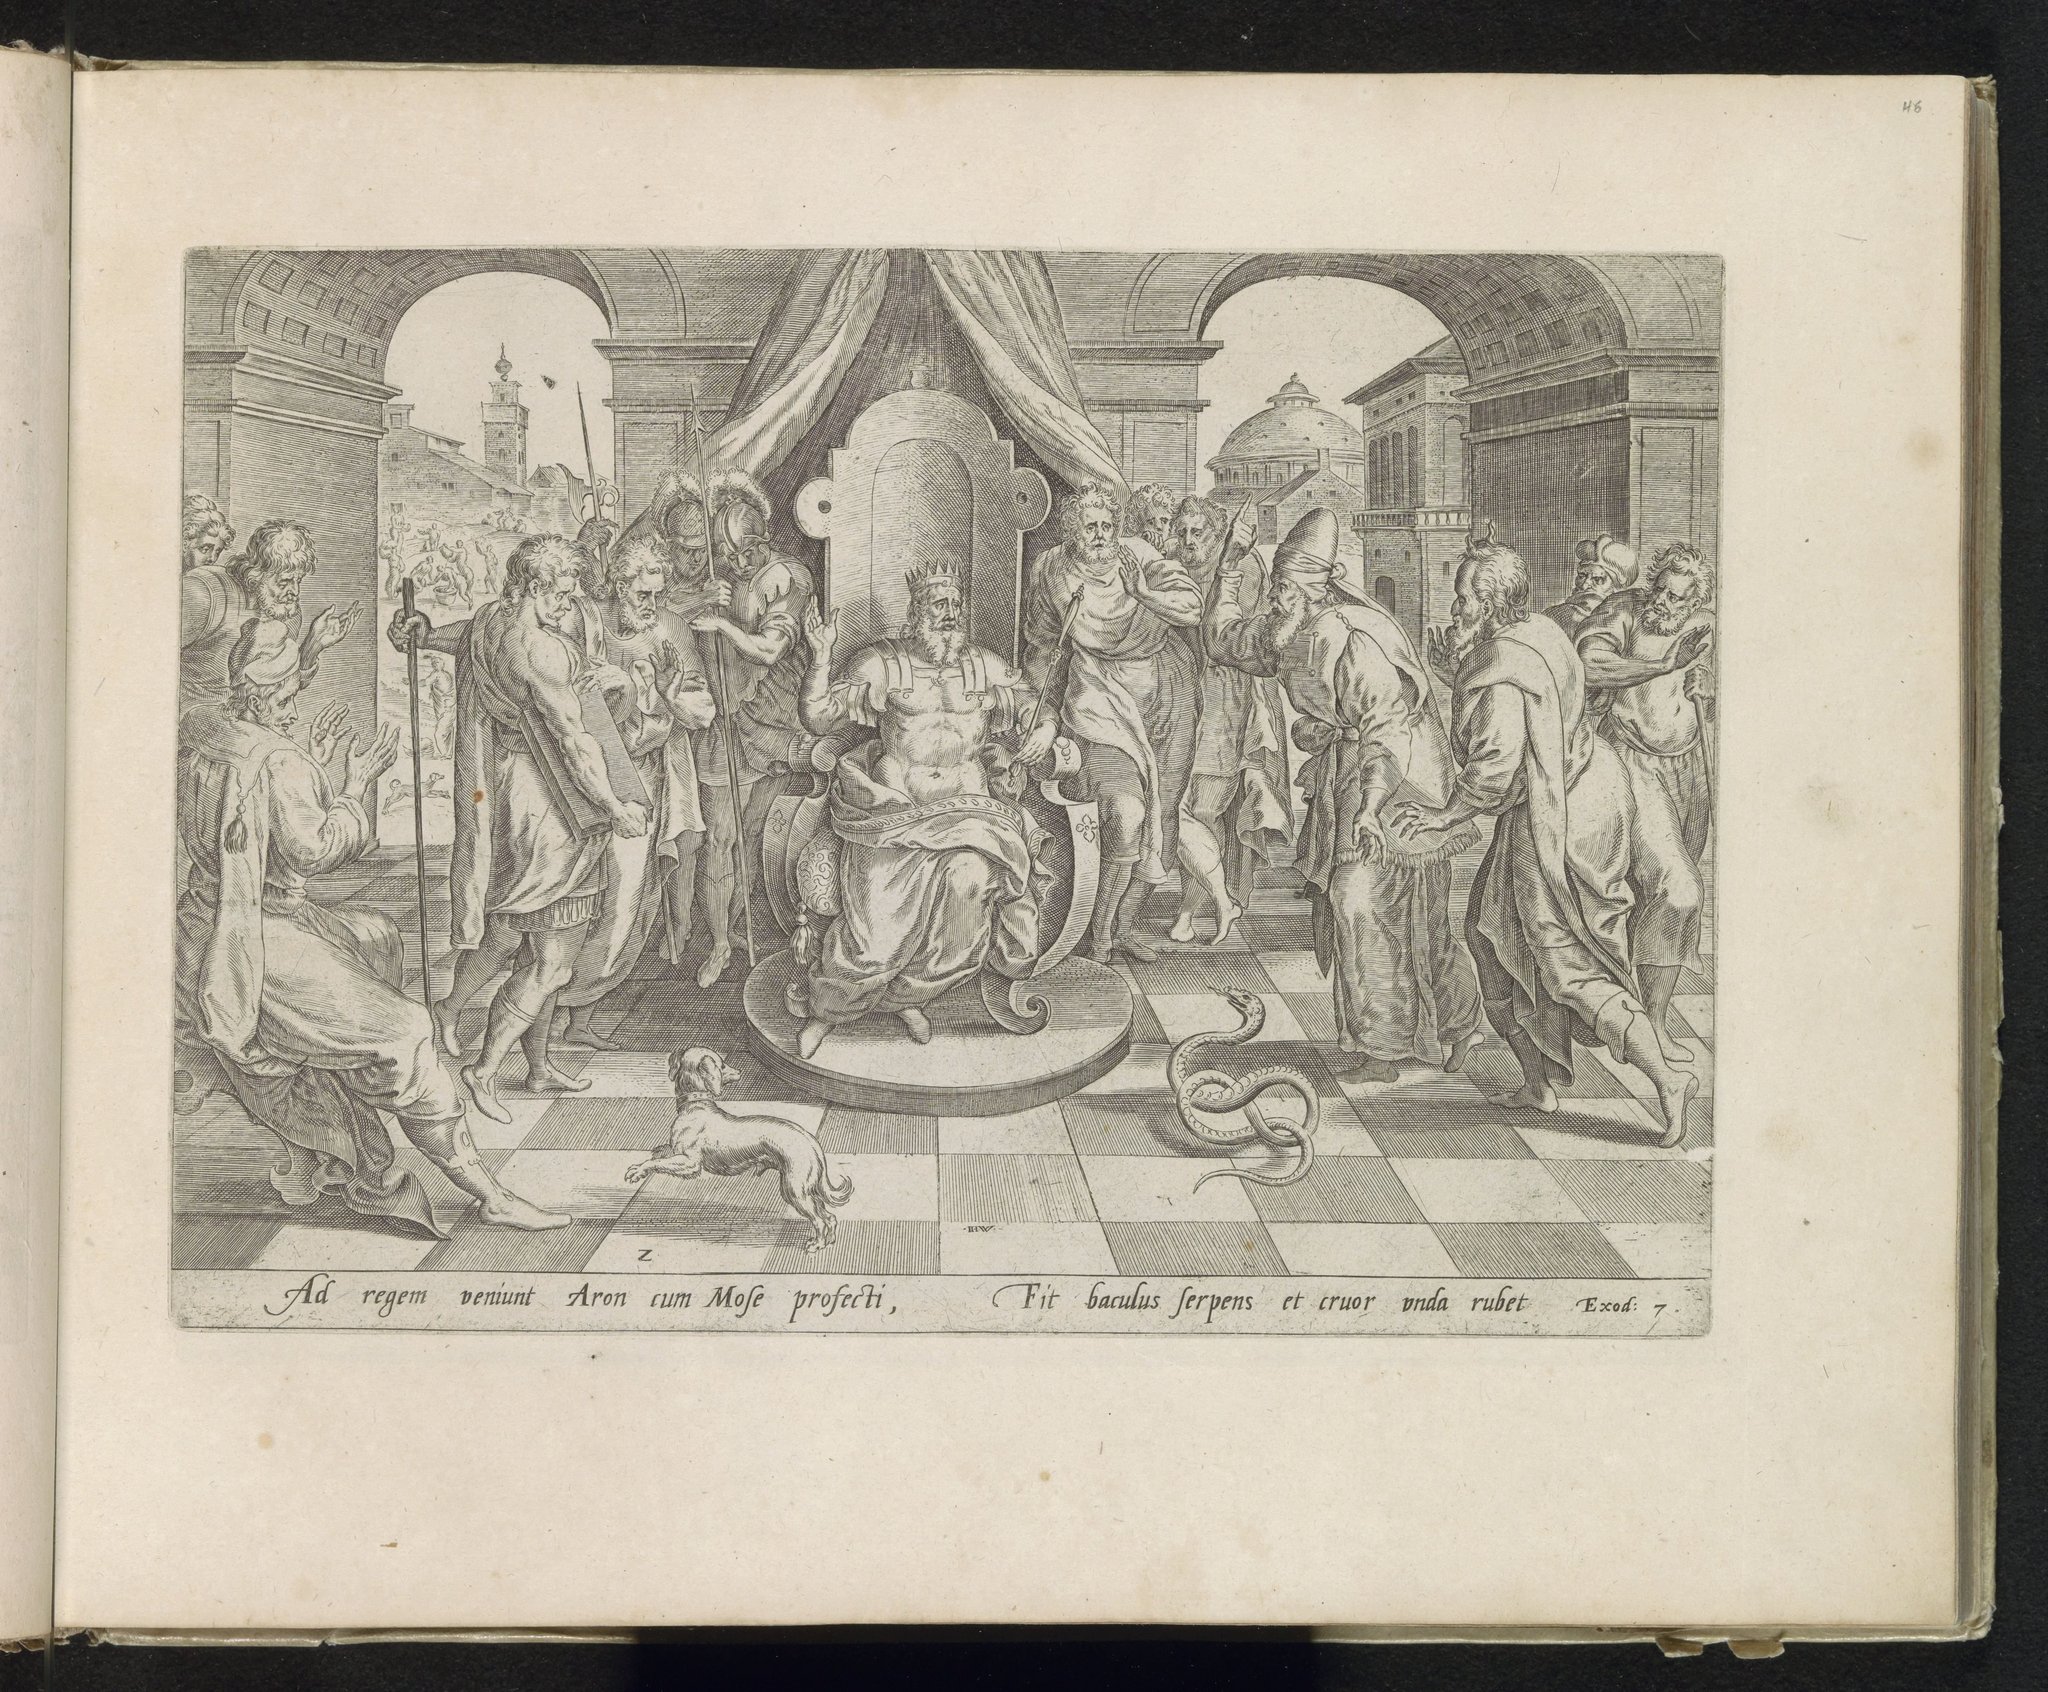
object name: album leaf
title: Thesaurus sacrarum historiaru[m] veteris testame[n]ti, elega[n]tissimis imaginibus expressu[m] excelle[n]tissimoru[m] in hac arte viroru[m] opera: nu[n]c primu[m] in luce[m] editus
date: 1585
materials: paper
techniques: engraving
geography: antwerp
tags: moses and aaron before pharaoh; aaron performs the miracle of the rod changing into a snake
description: Mozes en Aäron spreken met de farao en vragen hem het volk van Israël te laten gaan. Aäron heeft zijn staf op de grond gegooid en de staf is in een slang veranderd. De hofhouding van de farao kijkt verbaasd toe. Onder de voorstelling een verwijzing in het Latijn naar de Bijbeltekst in Ex. 7. Deze prent maakt deel uit van een album.